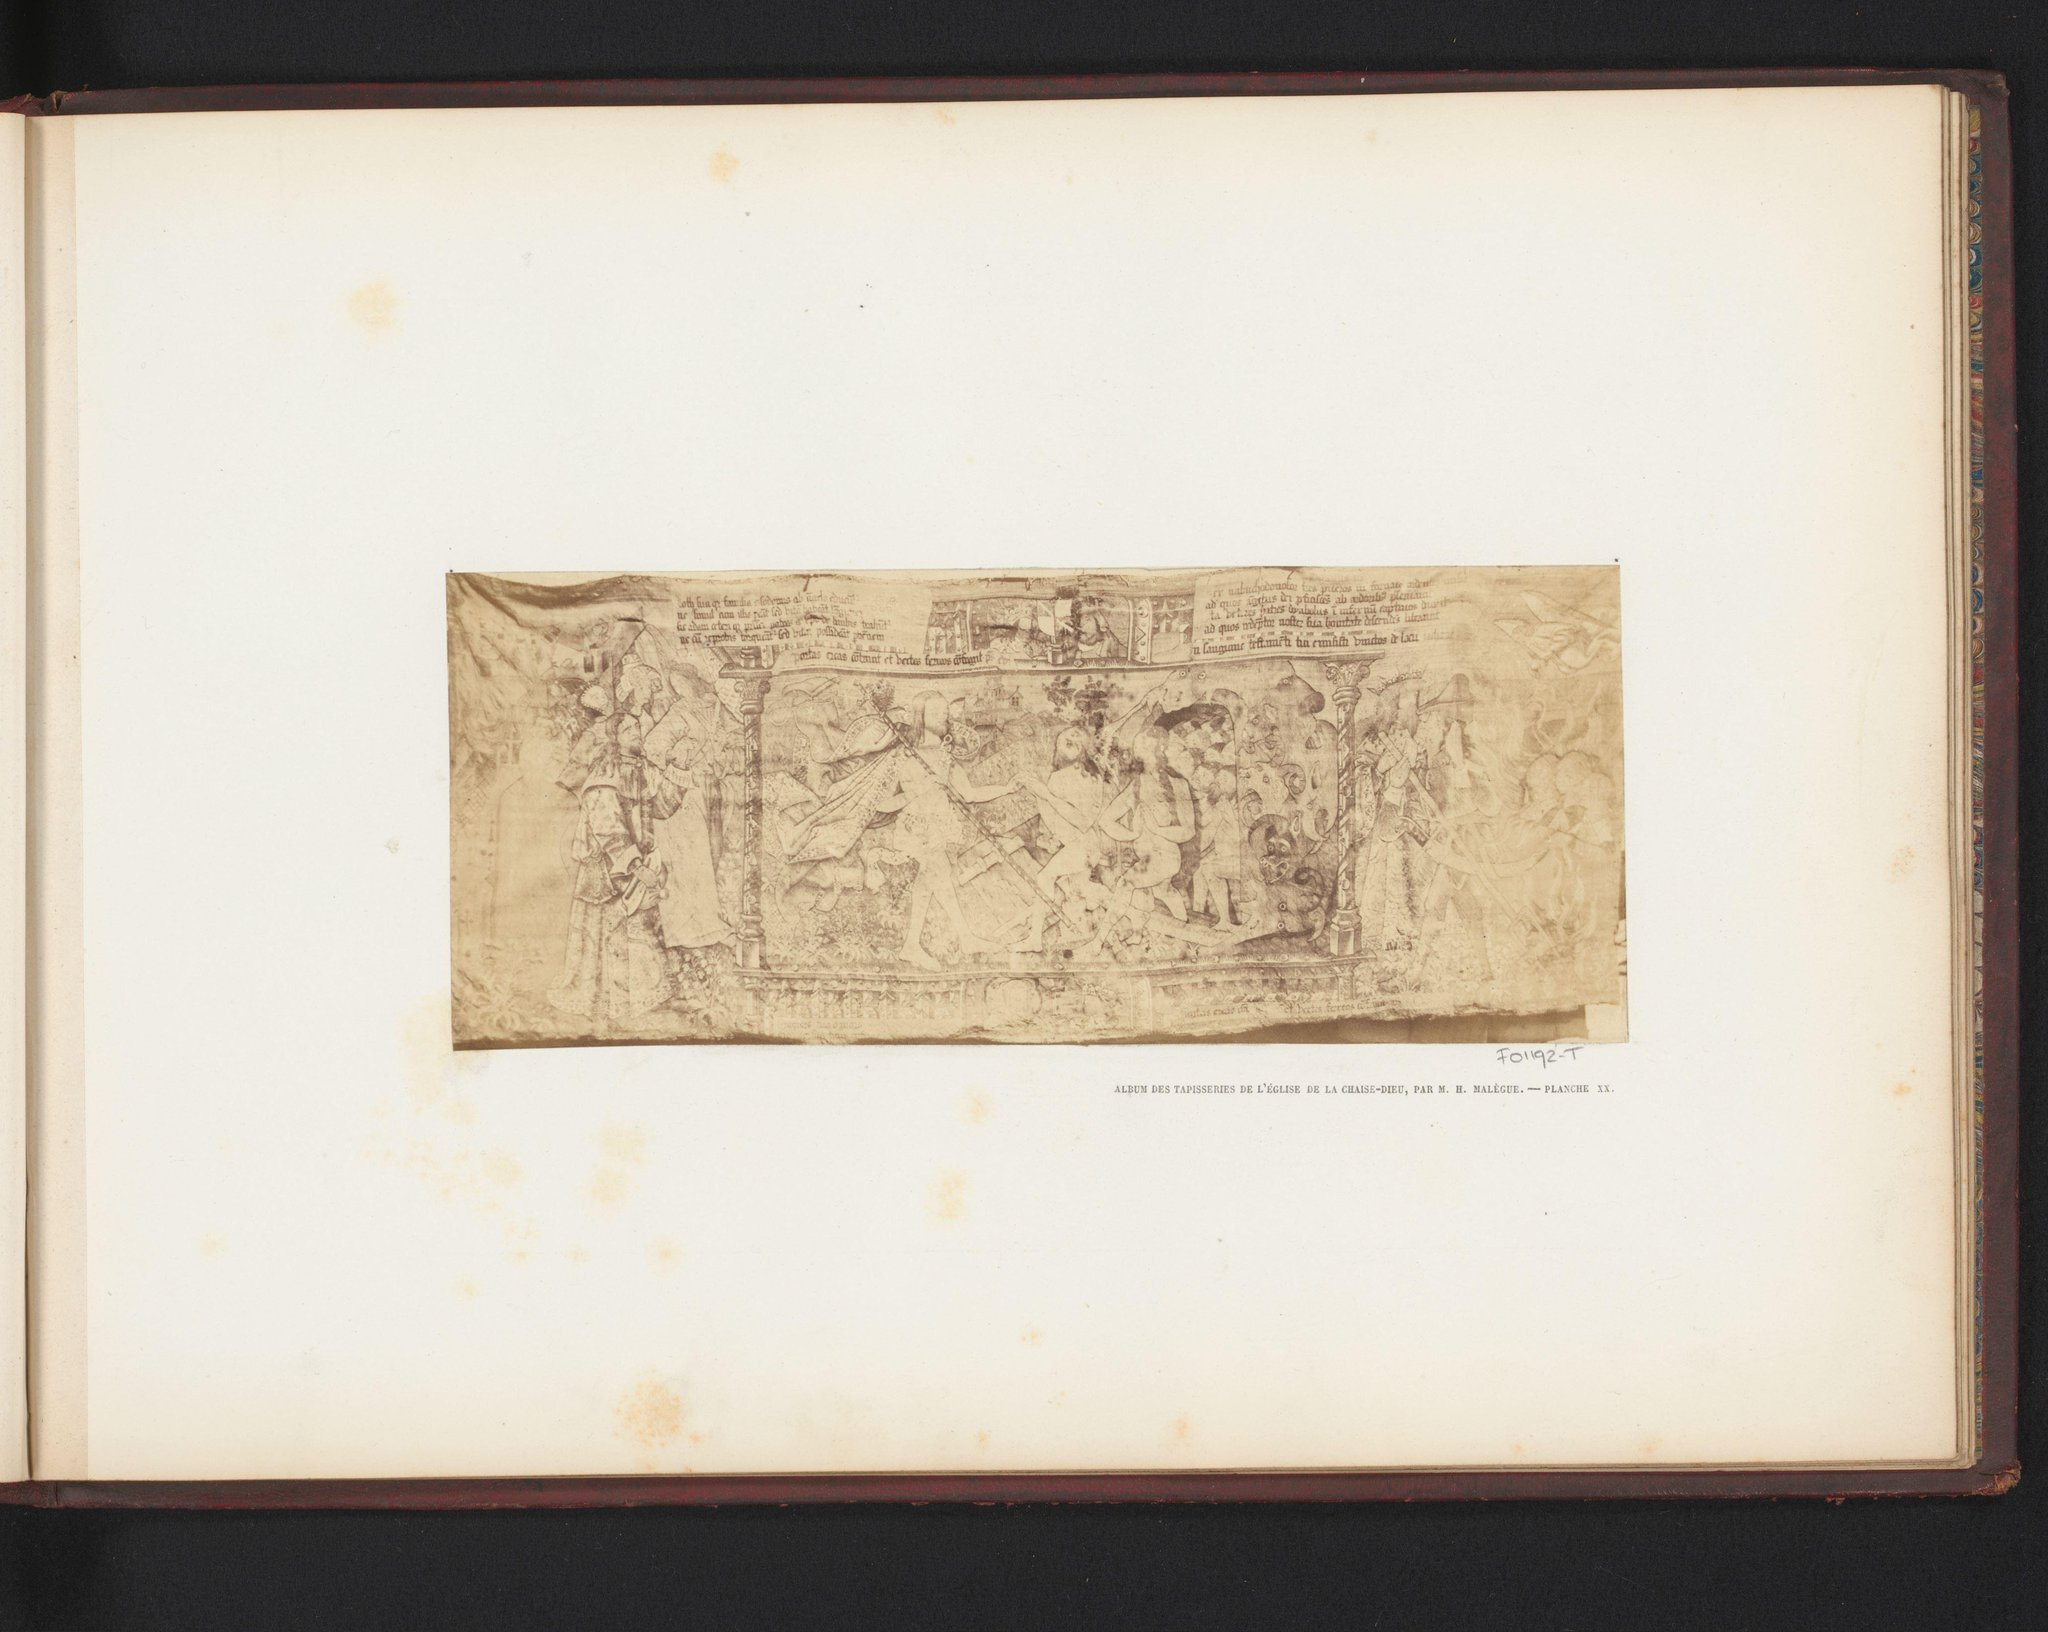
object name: photograph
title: Tapijt met Christus en de hellepoort en prefiguraties in een kerk te La Chaise-Dieu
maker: hippolyte malègue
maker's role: archeoloog, fotograaf, schrijver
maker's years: 1825-1901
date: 1868-1873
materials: photographic support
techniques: albumen print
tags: tapestry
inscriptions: inscription: ‘album des tapisseries de l'église de la Chaise-Dieu, par M. H. Malegue - Planche XX’